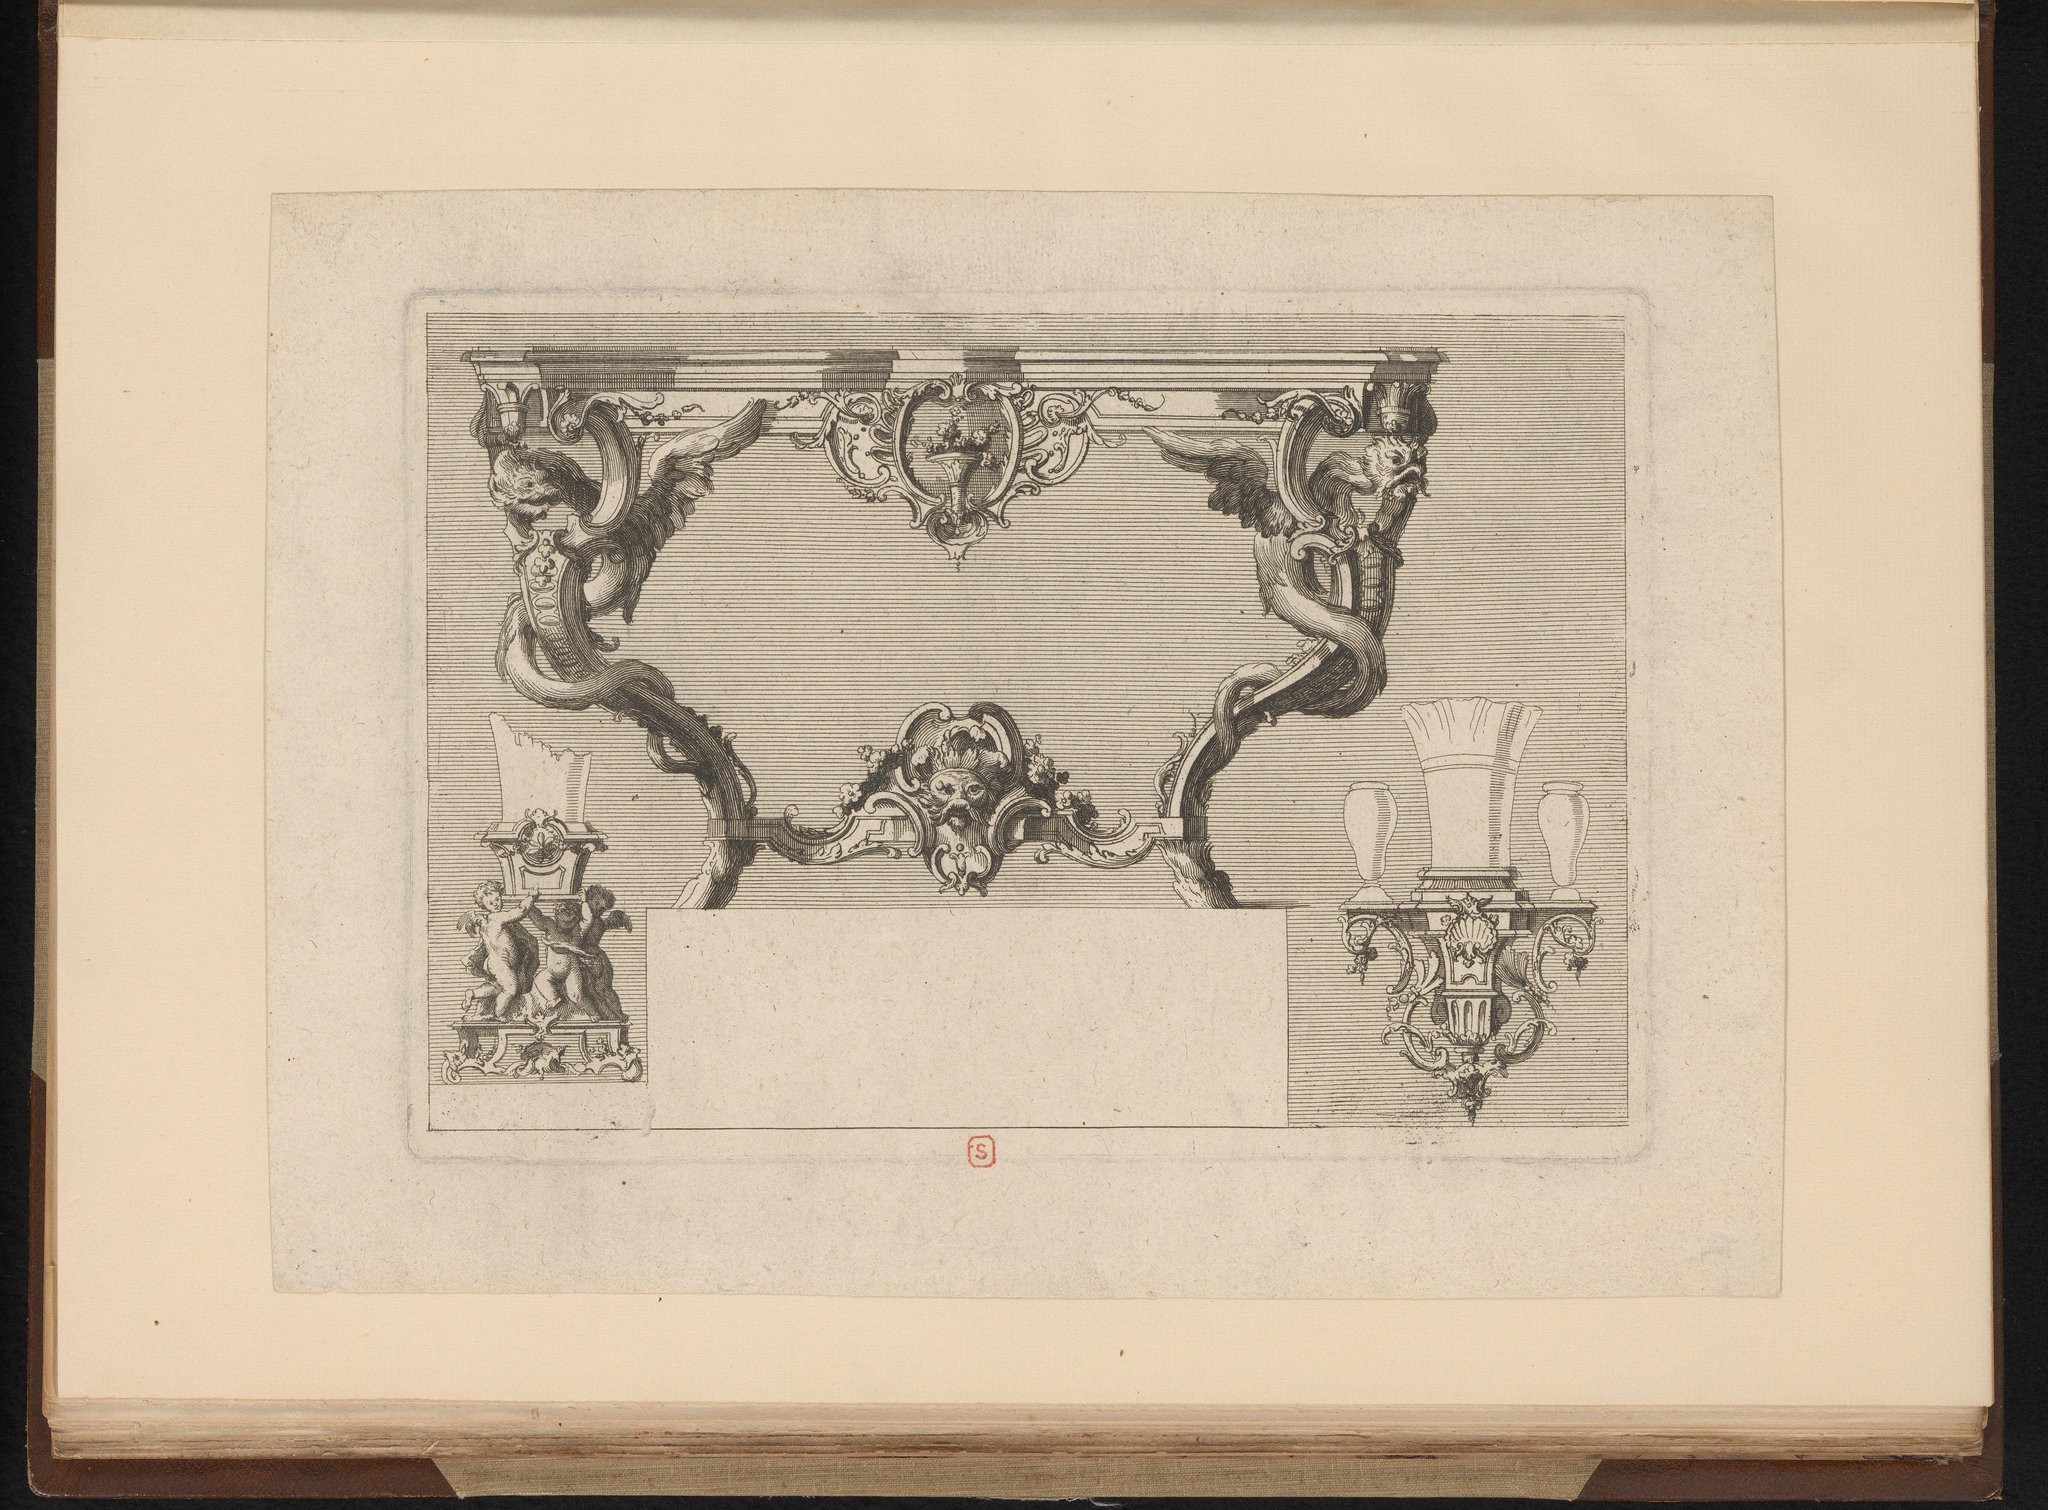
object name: print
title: Nieuwe ontwerpen van tafelpoten en consoles in hout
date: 1725-1750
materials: paper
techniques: etching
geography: paris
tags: ornaments ~ art, sconce, wall lamp, table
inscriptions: collector's mark: Lugt 2342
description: Deze prent maakt deel uit van een album.